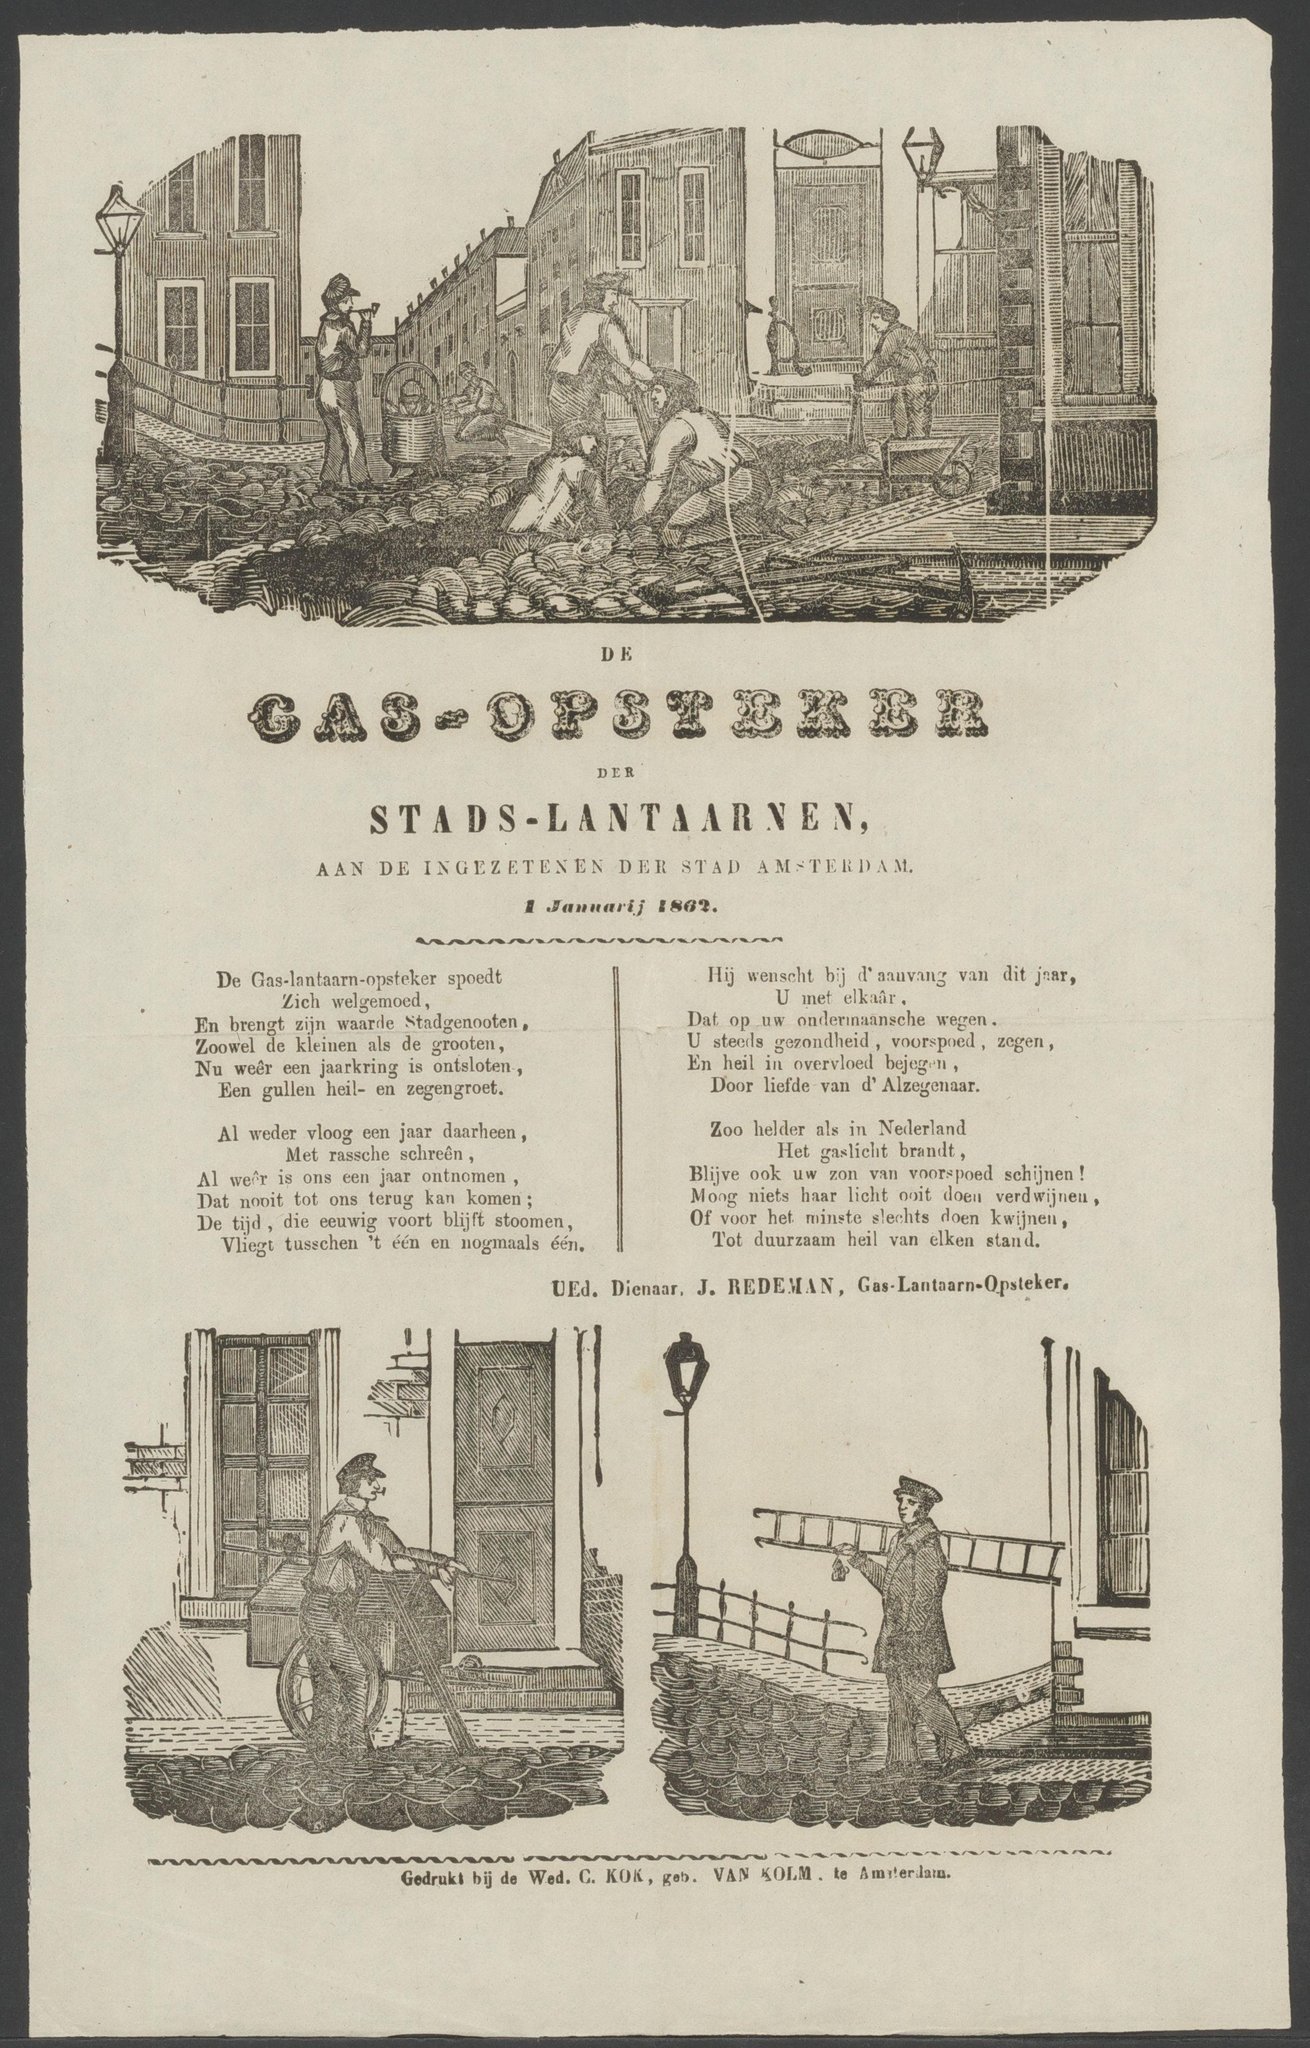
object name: print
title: Nieuwjaarswens van de gaslantaarnopstekers van Amsterdam voor het jaar 1862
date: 1861-1862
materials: paper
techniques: letterpress printing, engraving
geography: amsterdam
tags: gas-lamp, gas supply, digging (industrial process), street lighting, amsterdam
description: Nieuwjaarswens van de Amsterdamse gaslantaarnopstekers voor het jaar 1862. Centraal een vers in twee kolommen. Bovenaan een straat in Amsterdam opgebroken voor de aanleg van de gasleiding. Onderaan twee gasfitters. Van de gaslantaarnopsteker: J. Redeman. Onderwerpsrubrieken binnen de Atlas Zeden en Gewoonten: Zeden en gewoonten in engeren zin, Volksleven, Volksbladen, Nieuwjaars- en Kerstwenschen, Amsterdam.